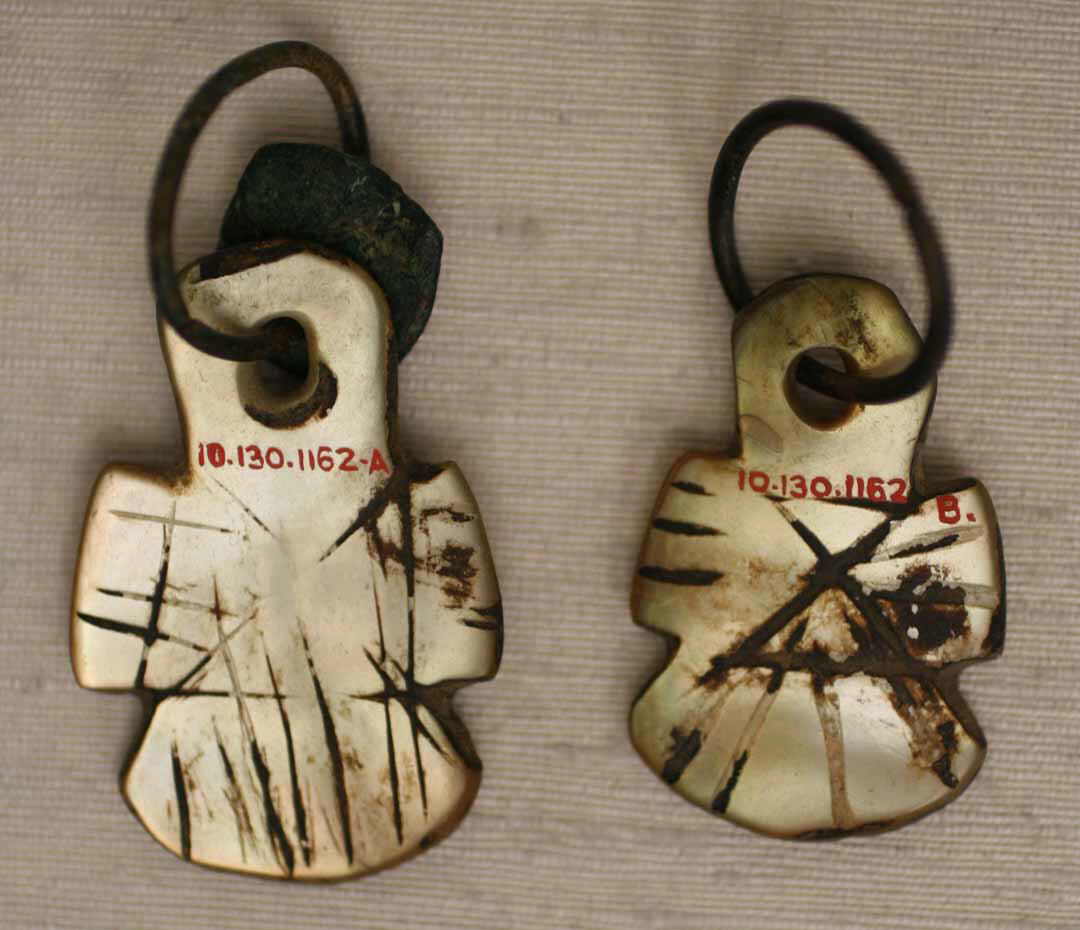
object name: cross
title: Crosses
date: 201-1200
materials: bronze, mother of pearl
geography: egypt